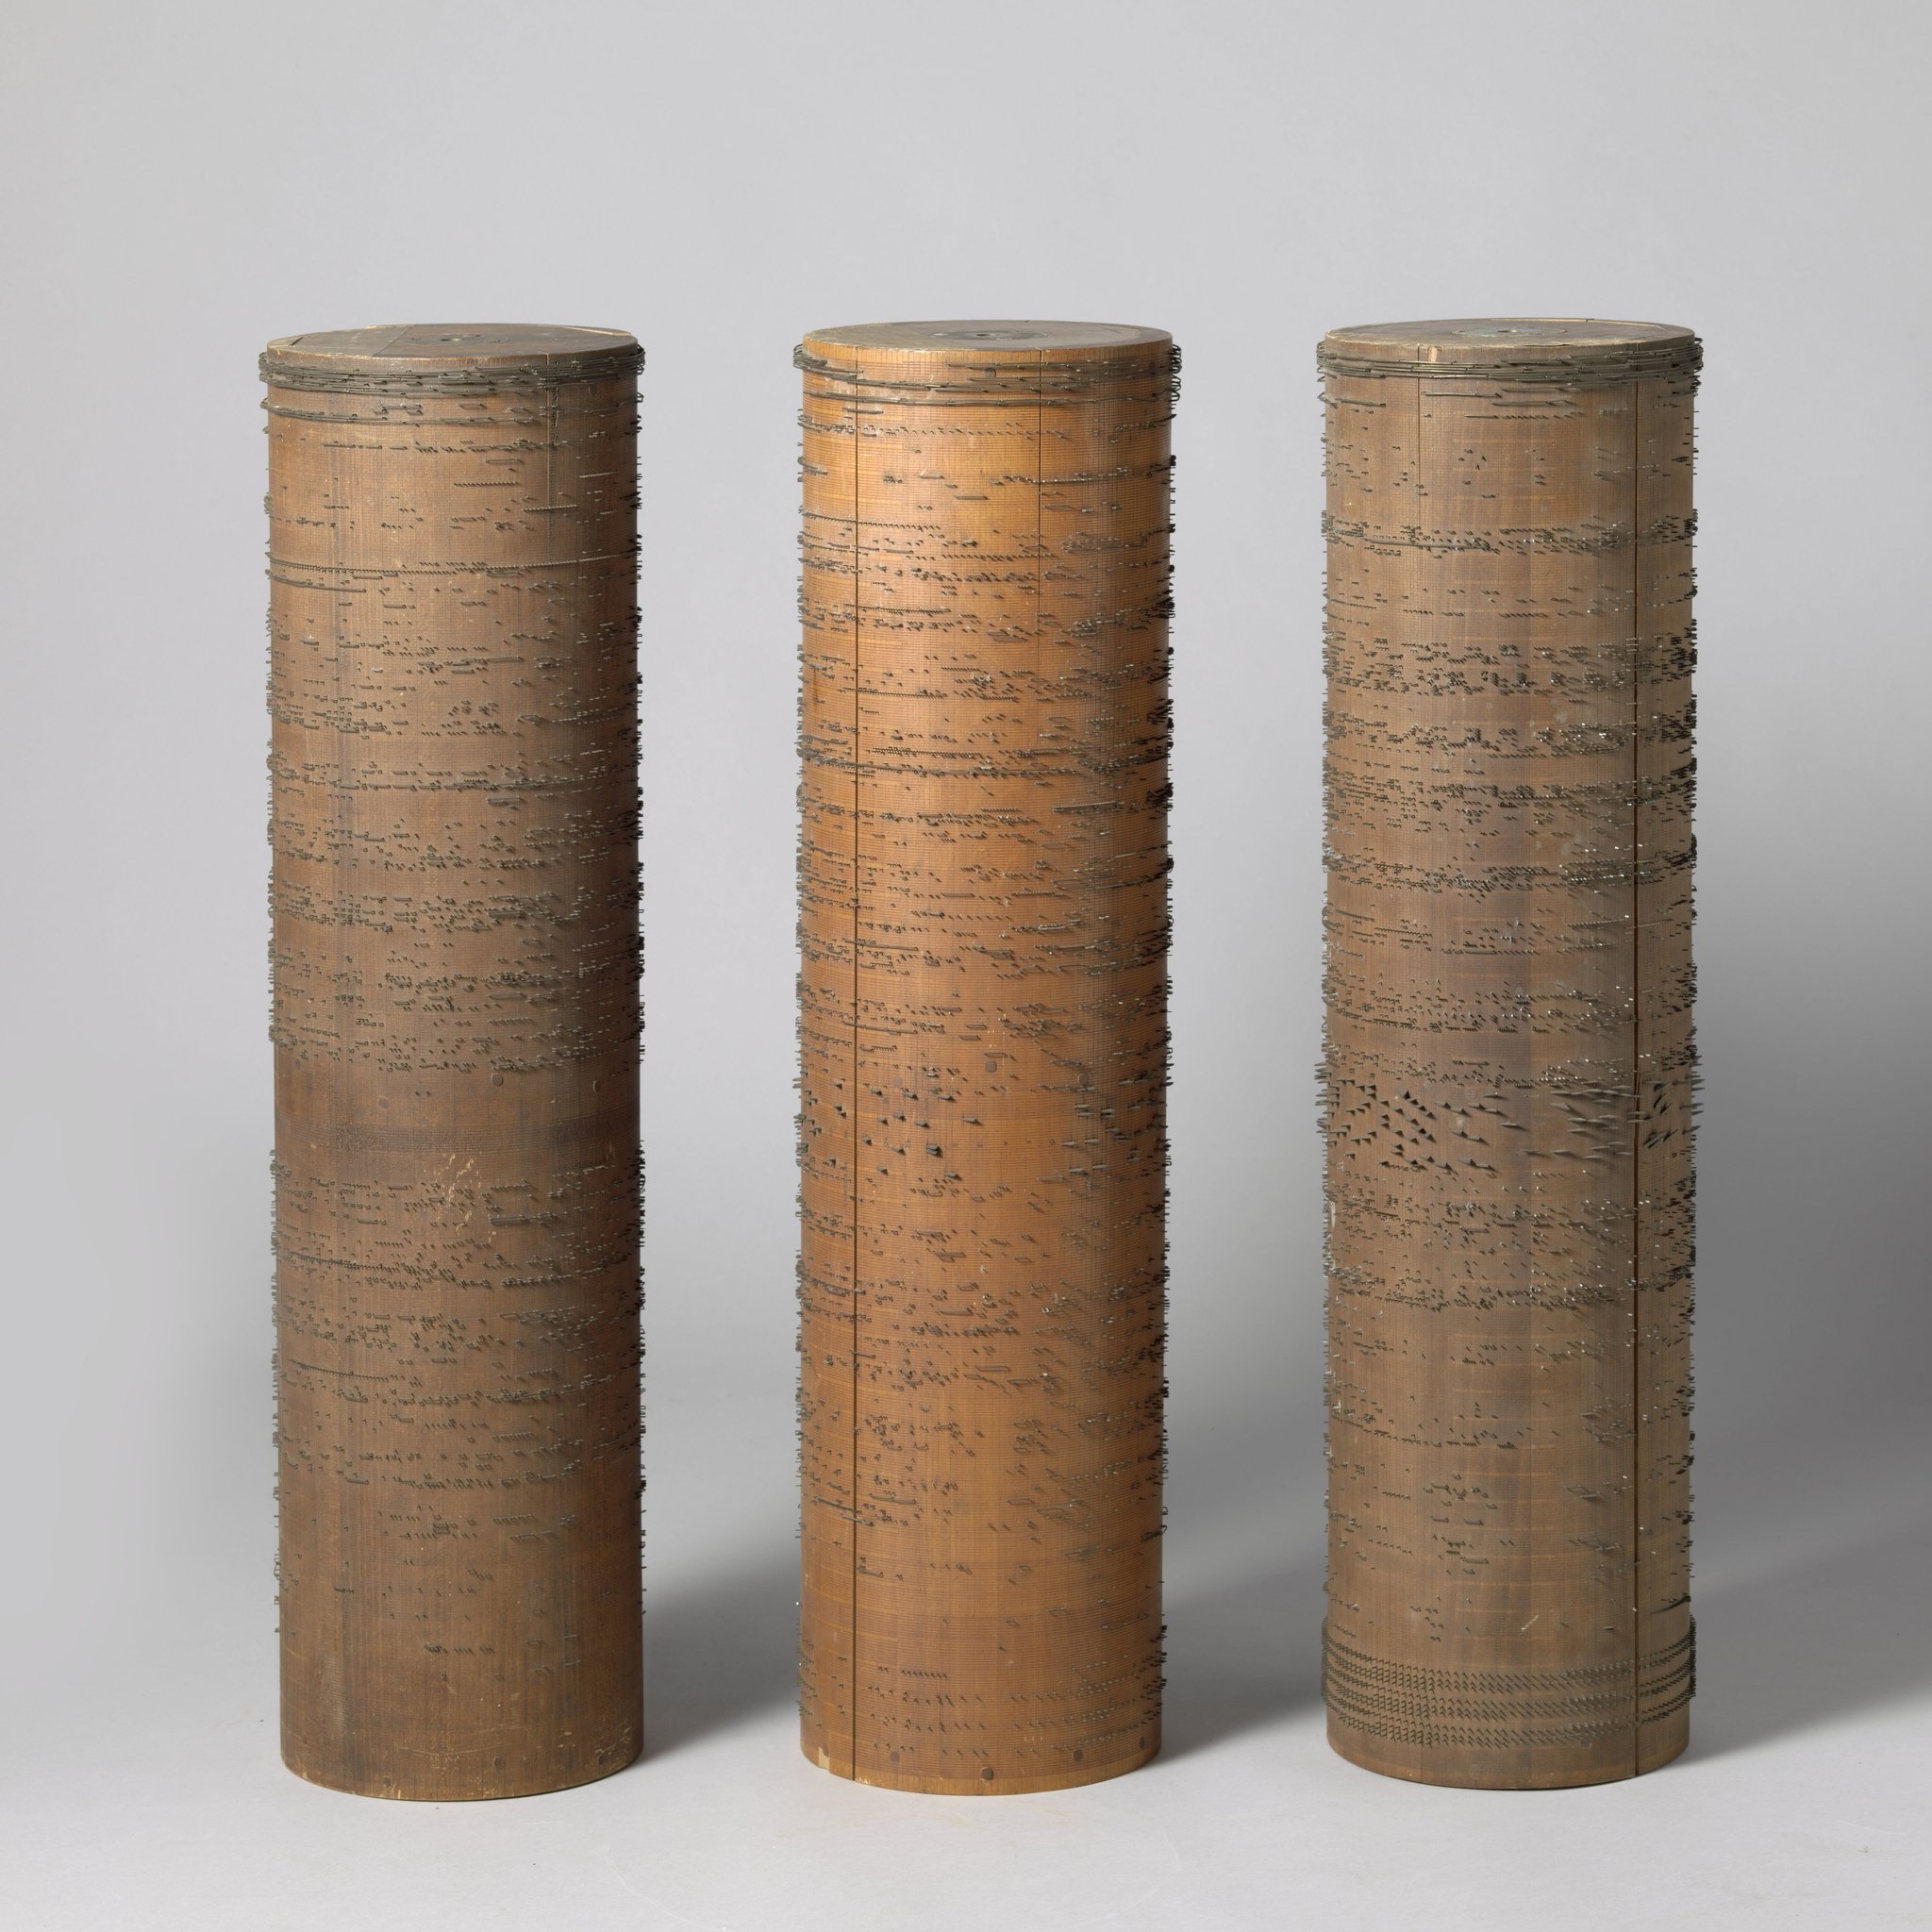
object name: mechanical instrument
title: Barrel for a mechanical organ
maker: harmanus dolman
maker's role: musical instrument maker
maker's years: 1787-1852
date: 1815-1825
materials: metal, wood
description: Cilinder voor een mechanisch orgel. 10 segmenten en 3 schroeven in messing plaat. Op de rol een handgeschreven tekst: Menuetto par Mozart en Variationes par Muller.